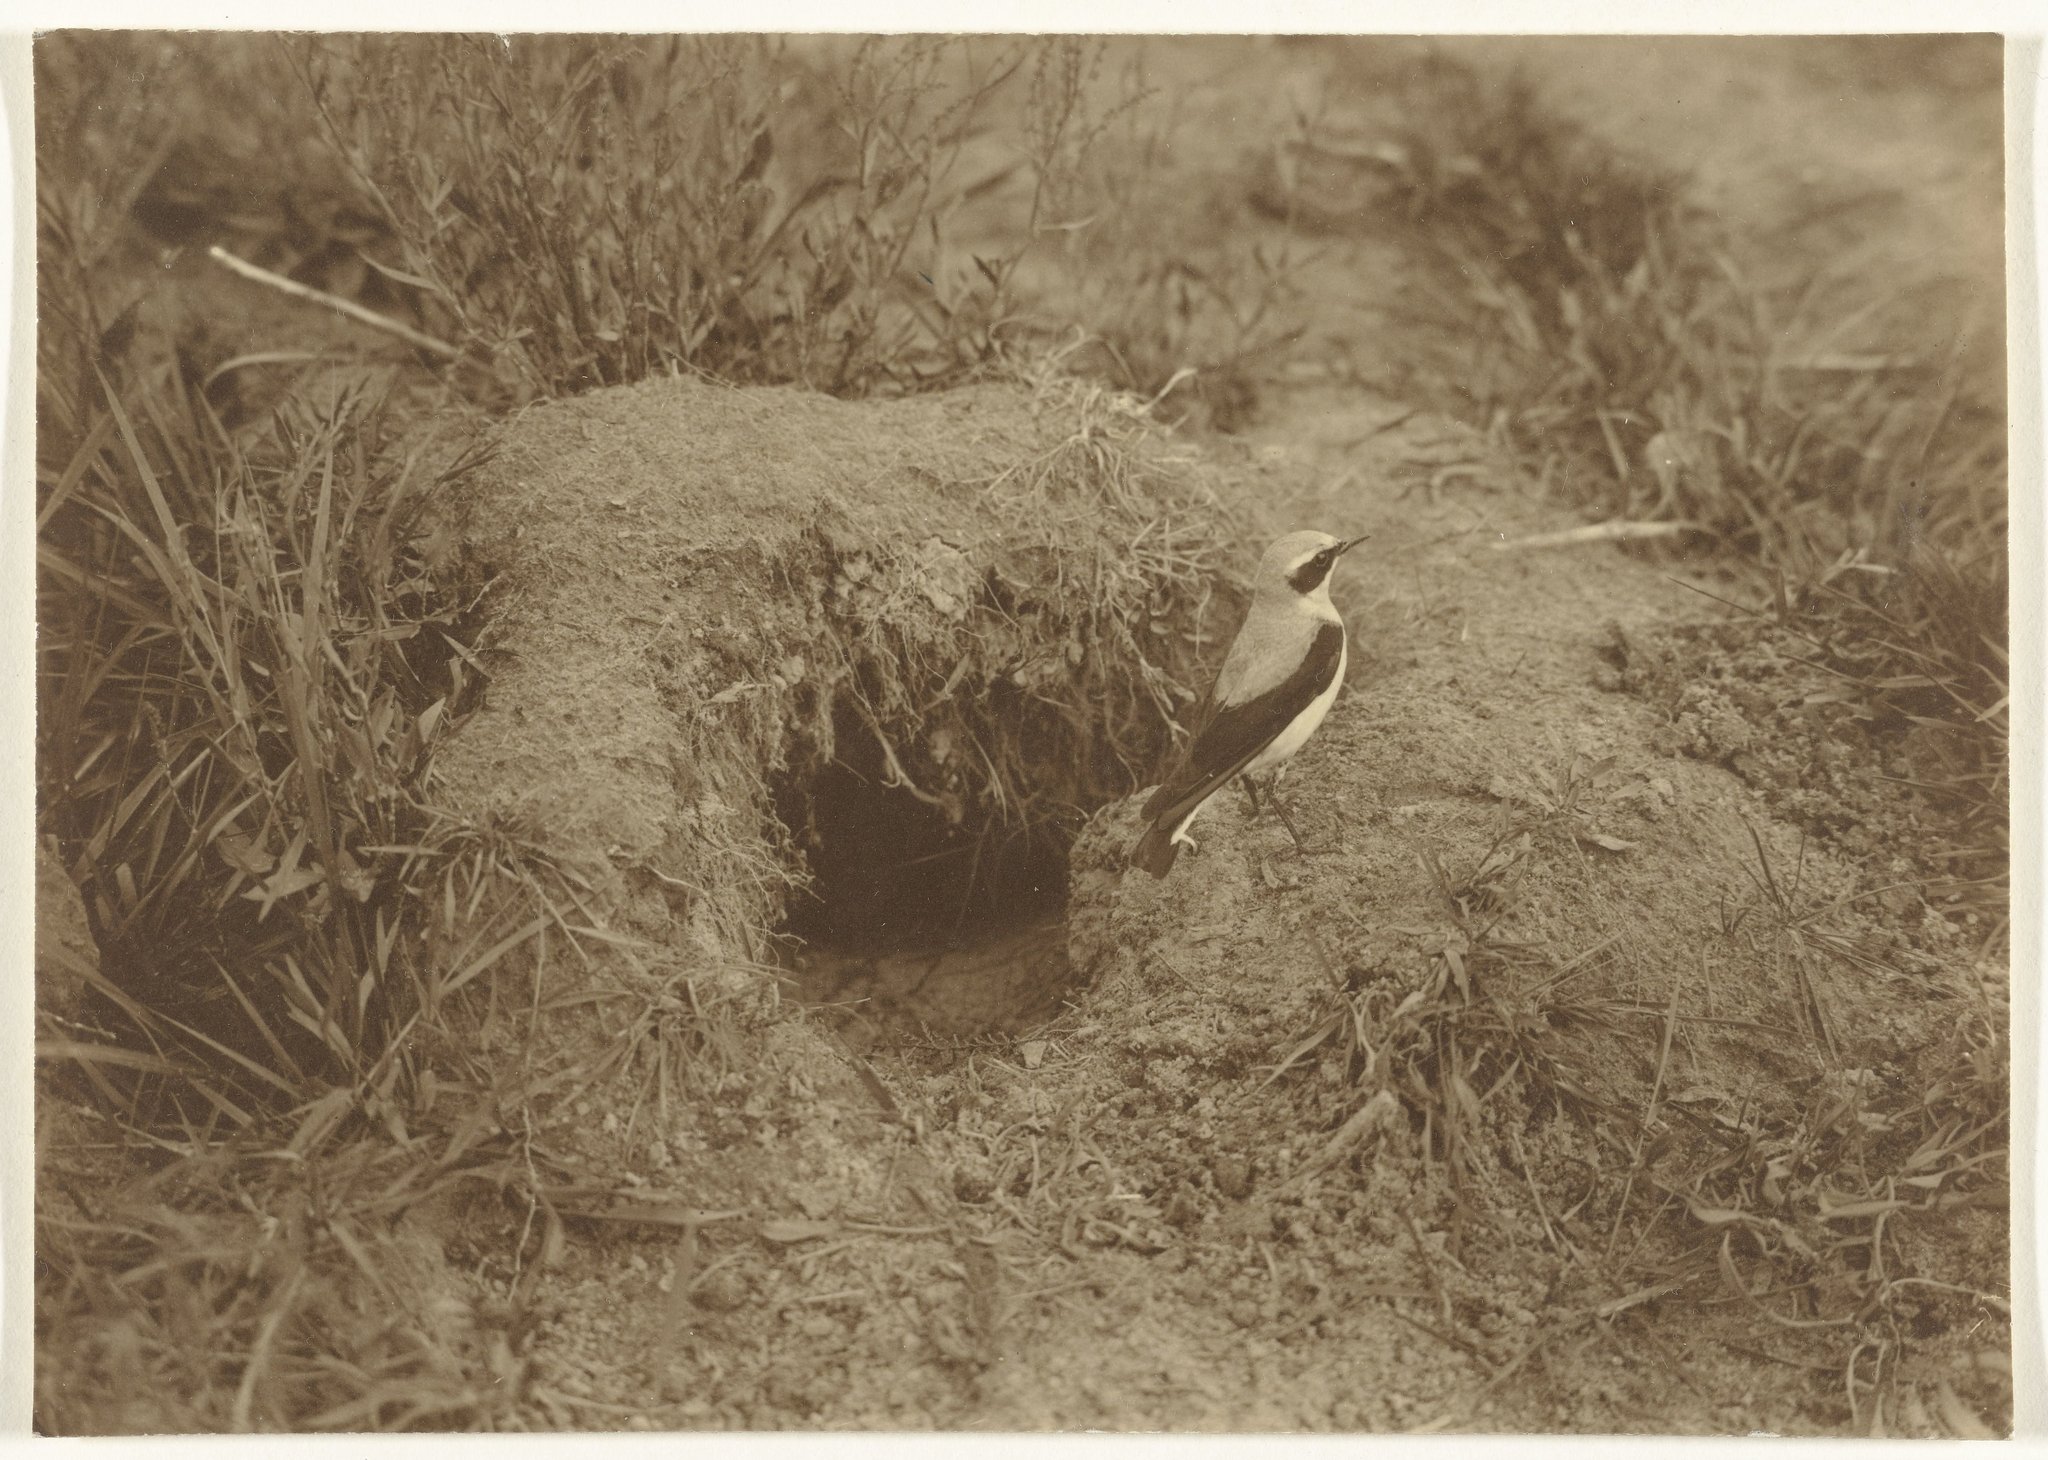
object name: photograph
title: Tapuit bij zijn nestholte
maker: richard tepe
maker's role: fotograaf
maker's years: 1864-1952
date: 1900-1930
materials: paper, photographic support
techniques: gelatin silver print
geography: netherlands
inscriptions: signature: ‘foto / R Tepe’, annotation: ‘Tapuit bij zijne nestholte’